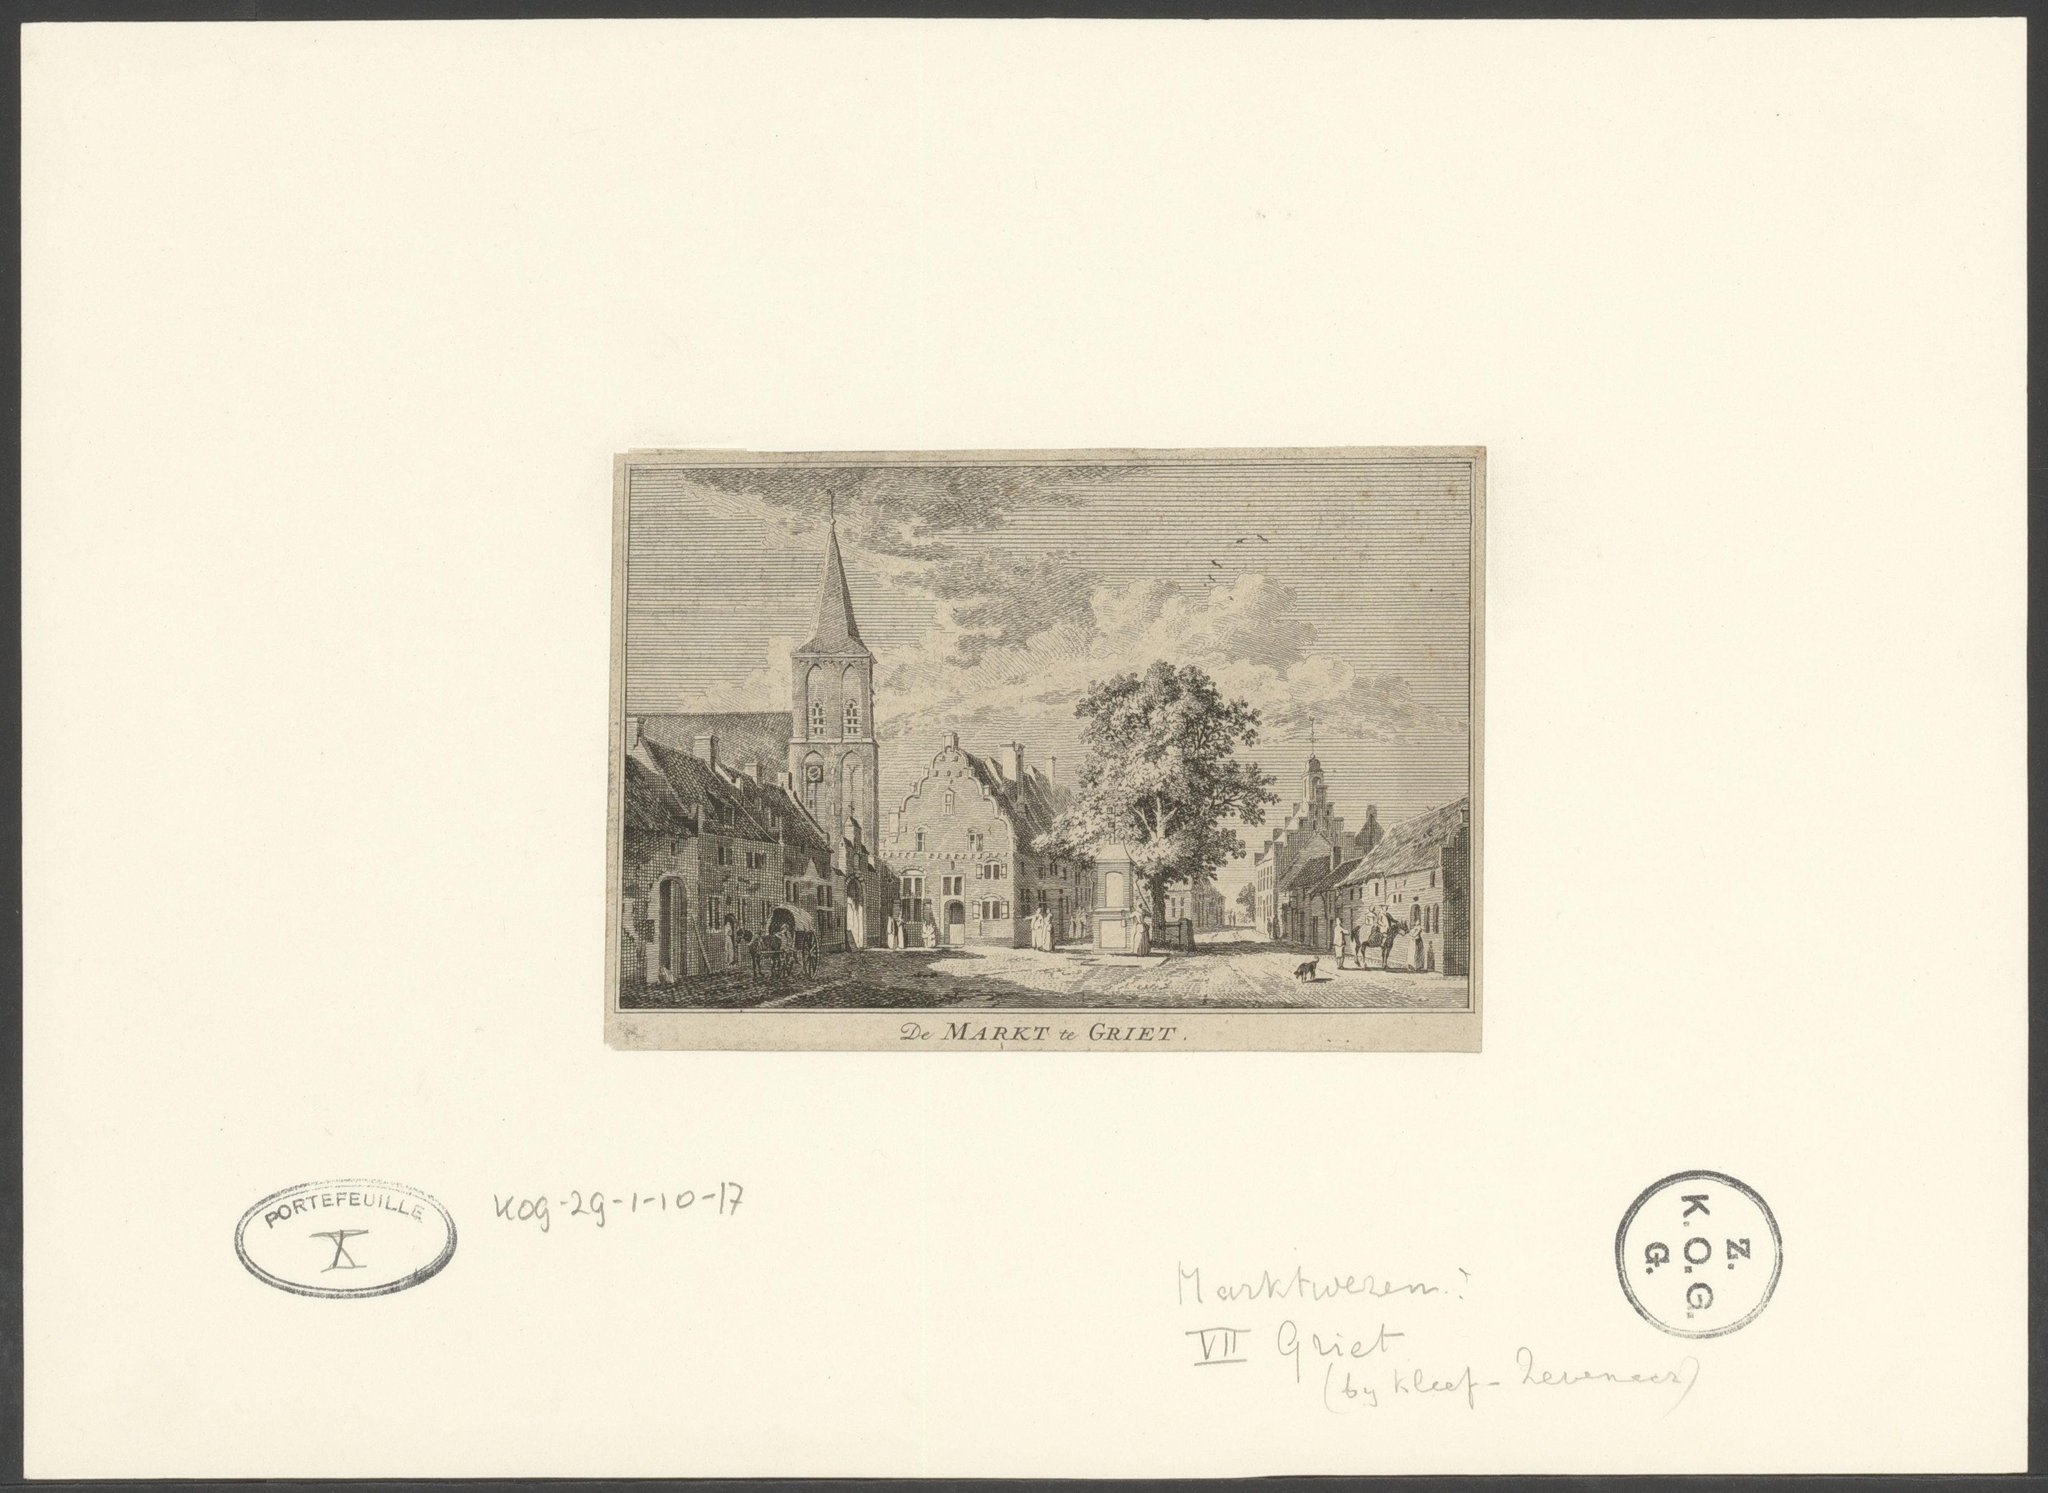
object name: print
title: Dorps- en stadsgezichten te Kleef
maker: paulus van liender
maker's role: draughtsman, print maker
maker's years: 1731-1797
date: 1792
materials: paper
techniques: etching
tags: church (exterior), market, village square, place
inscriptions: collector's mark: Lugt 1641, stamp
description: De prent maakt deel uit van een 100-delige serie met gezichten op dorpen en steden te Kleef. Prent mogelijk uit: Beijer, Jan de. Het verheerlykt Kleefschland of Kabinet van Kleefsche oudheden en gezigten. Amsterdam: Jan de Groot [etc.], 1792.